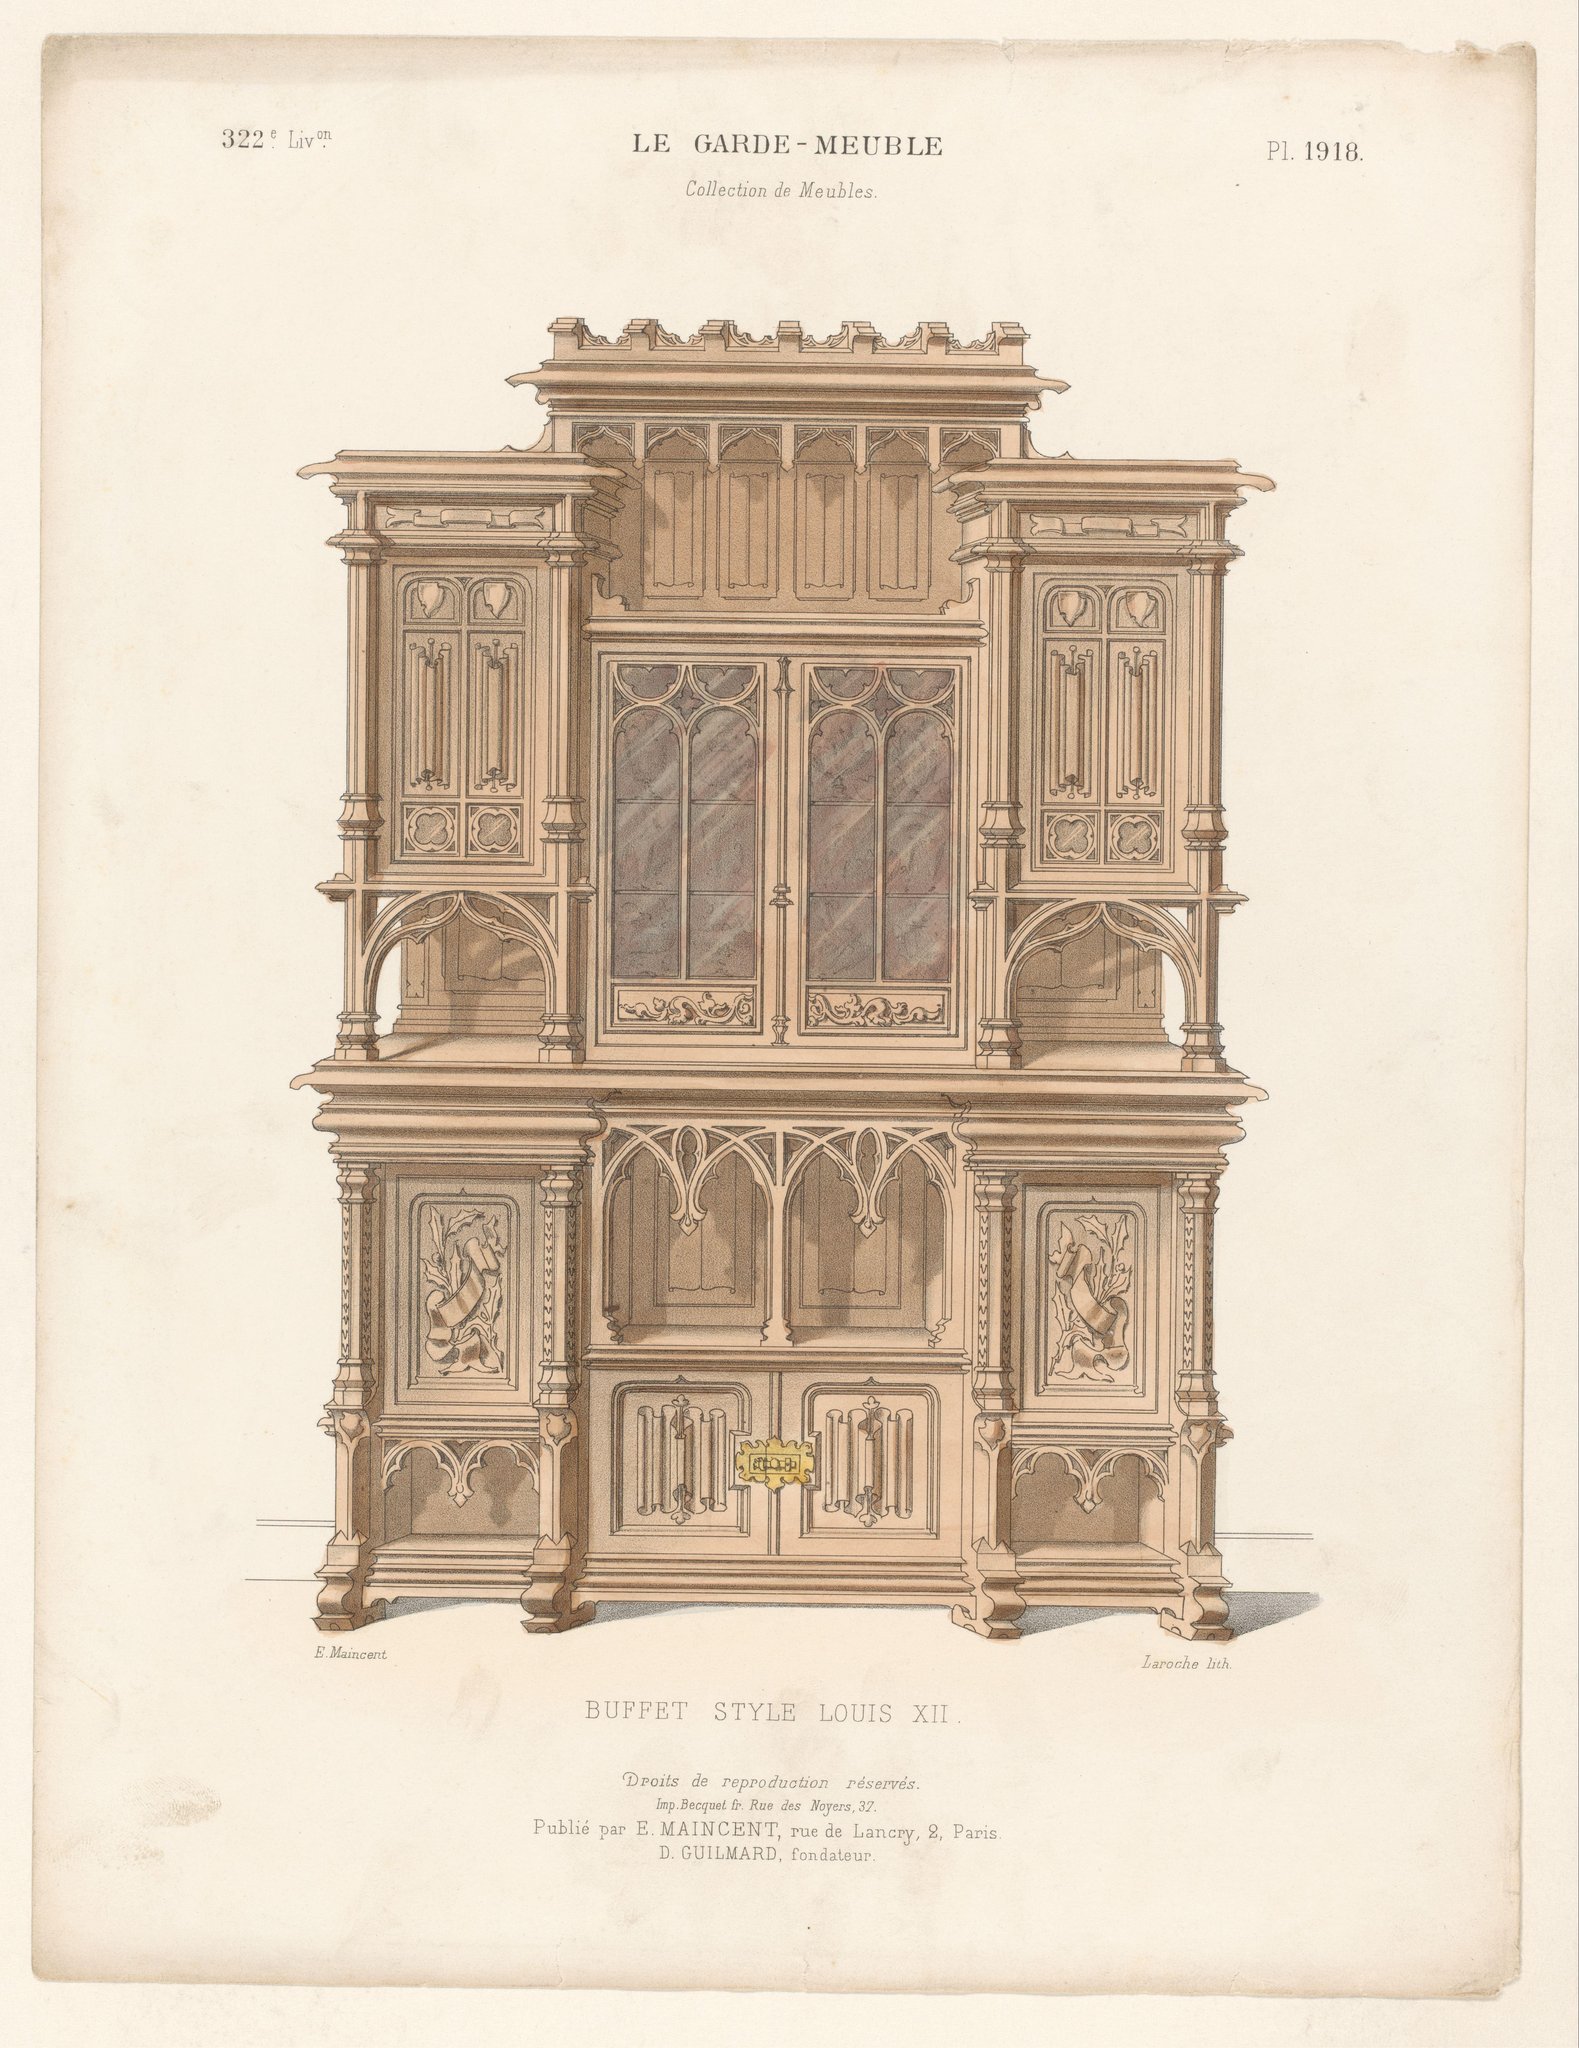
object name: print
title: Le garde-meuble / Collection de Meubles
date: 1885-1895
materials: paper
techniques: hand coloring, lithograph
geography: paris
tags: furniture for storage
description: Ieder Livraison in de serie Le Garde-Meuble bevat negen platen: drie 'sièges' (zitmeubels), drie 'meubles' (diverse meubels zoals tafels en kasten) en drie 'tentures' (gordijnen en draperieën).